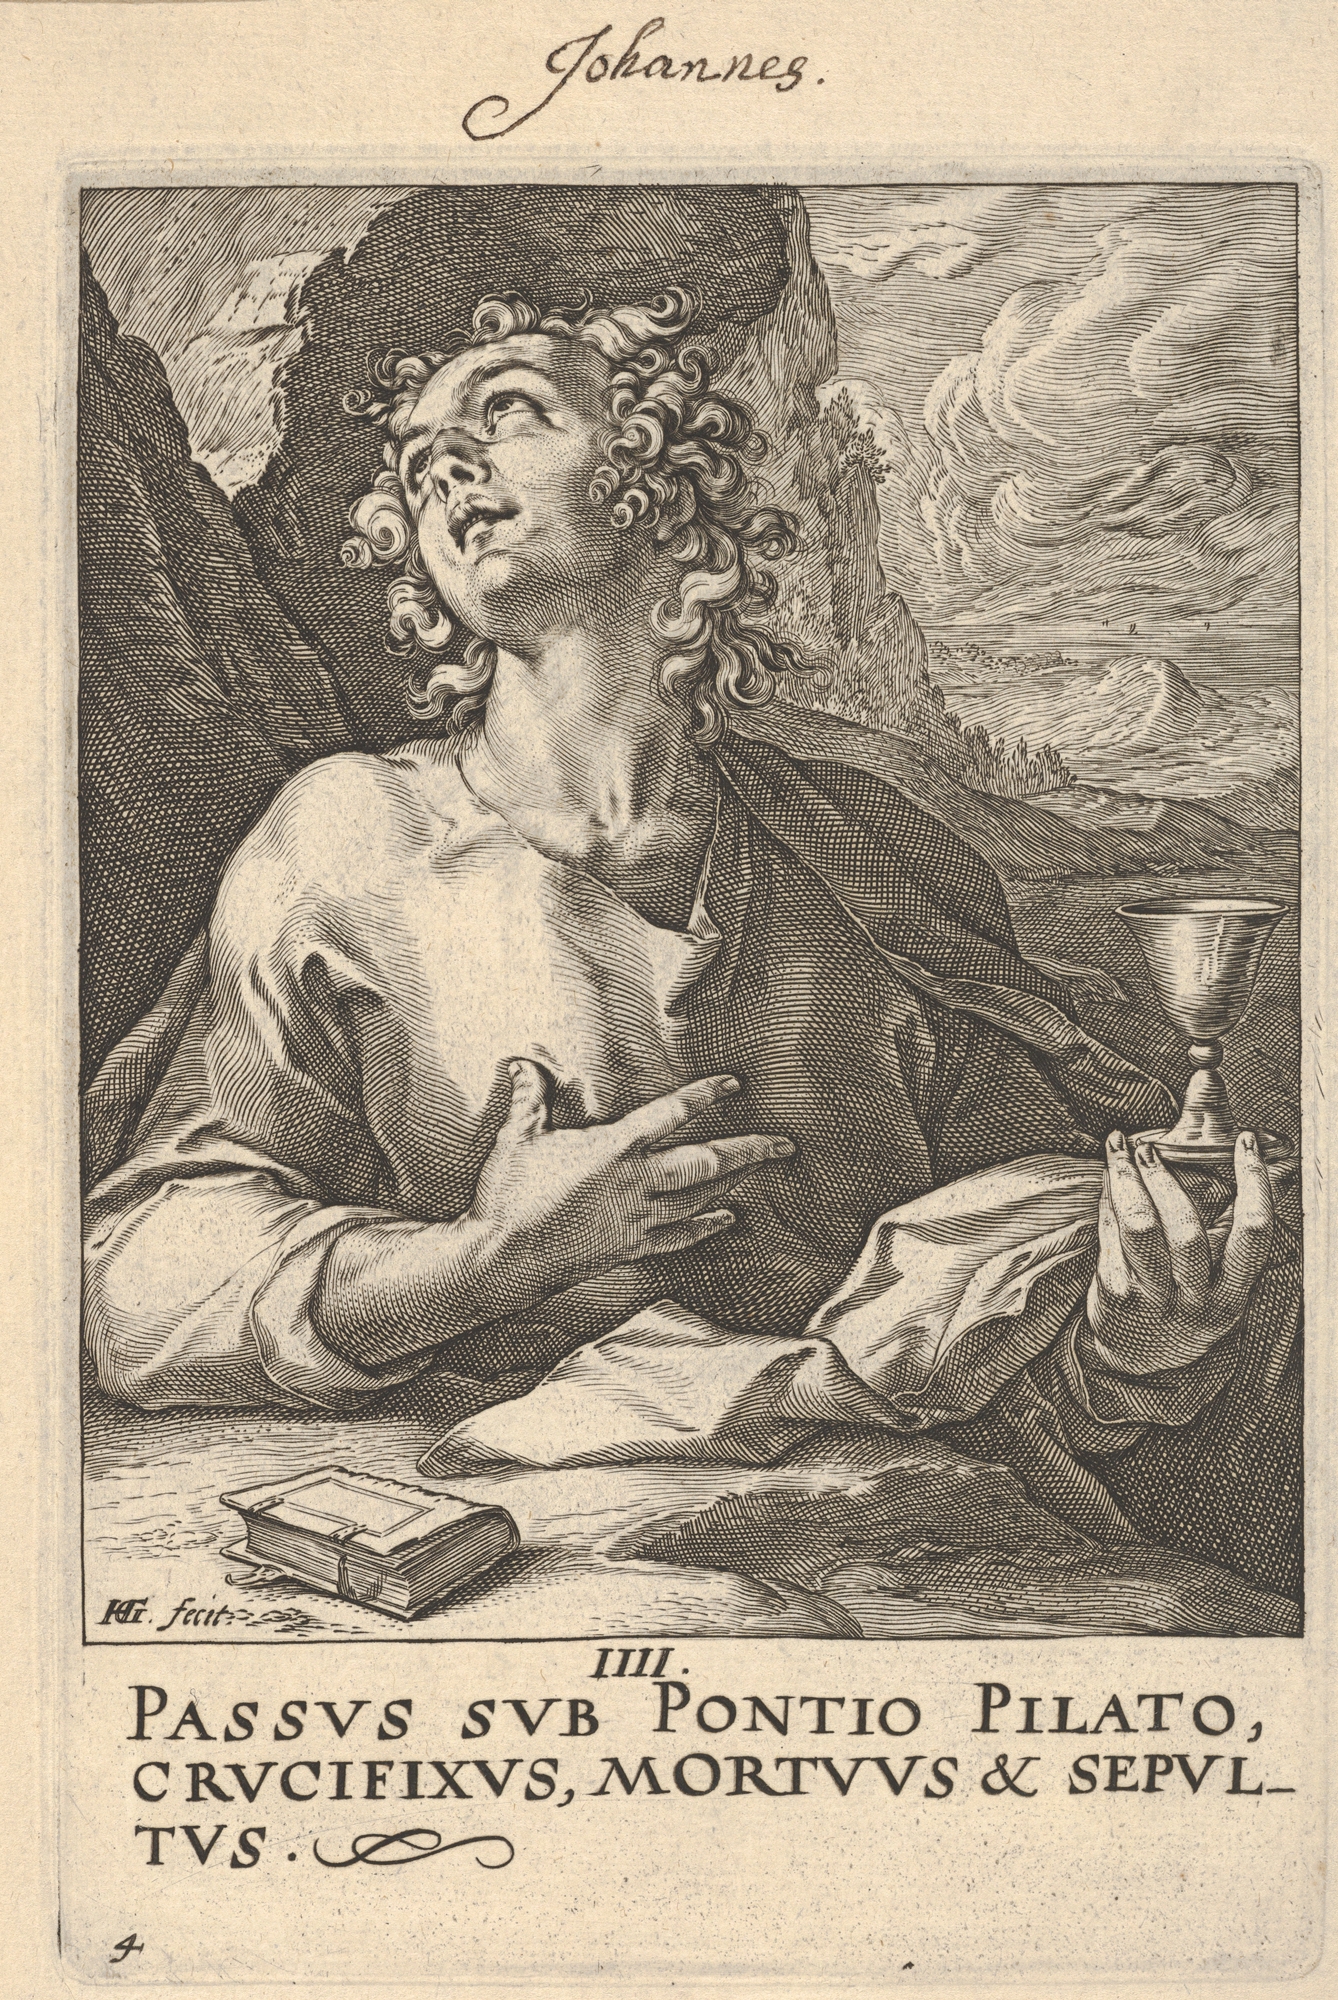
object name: print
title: St. John, from "Christ, the Apostles and St. Paul with the Creed"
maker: hendrick goltzius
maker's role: artist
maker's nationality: netherlandish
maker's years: 1558-1617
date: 1589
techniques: engraving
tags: men,saint paul